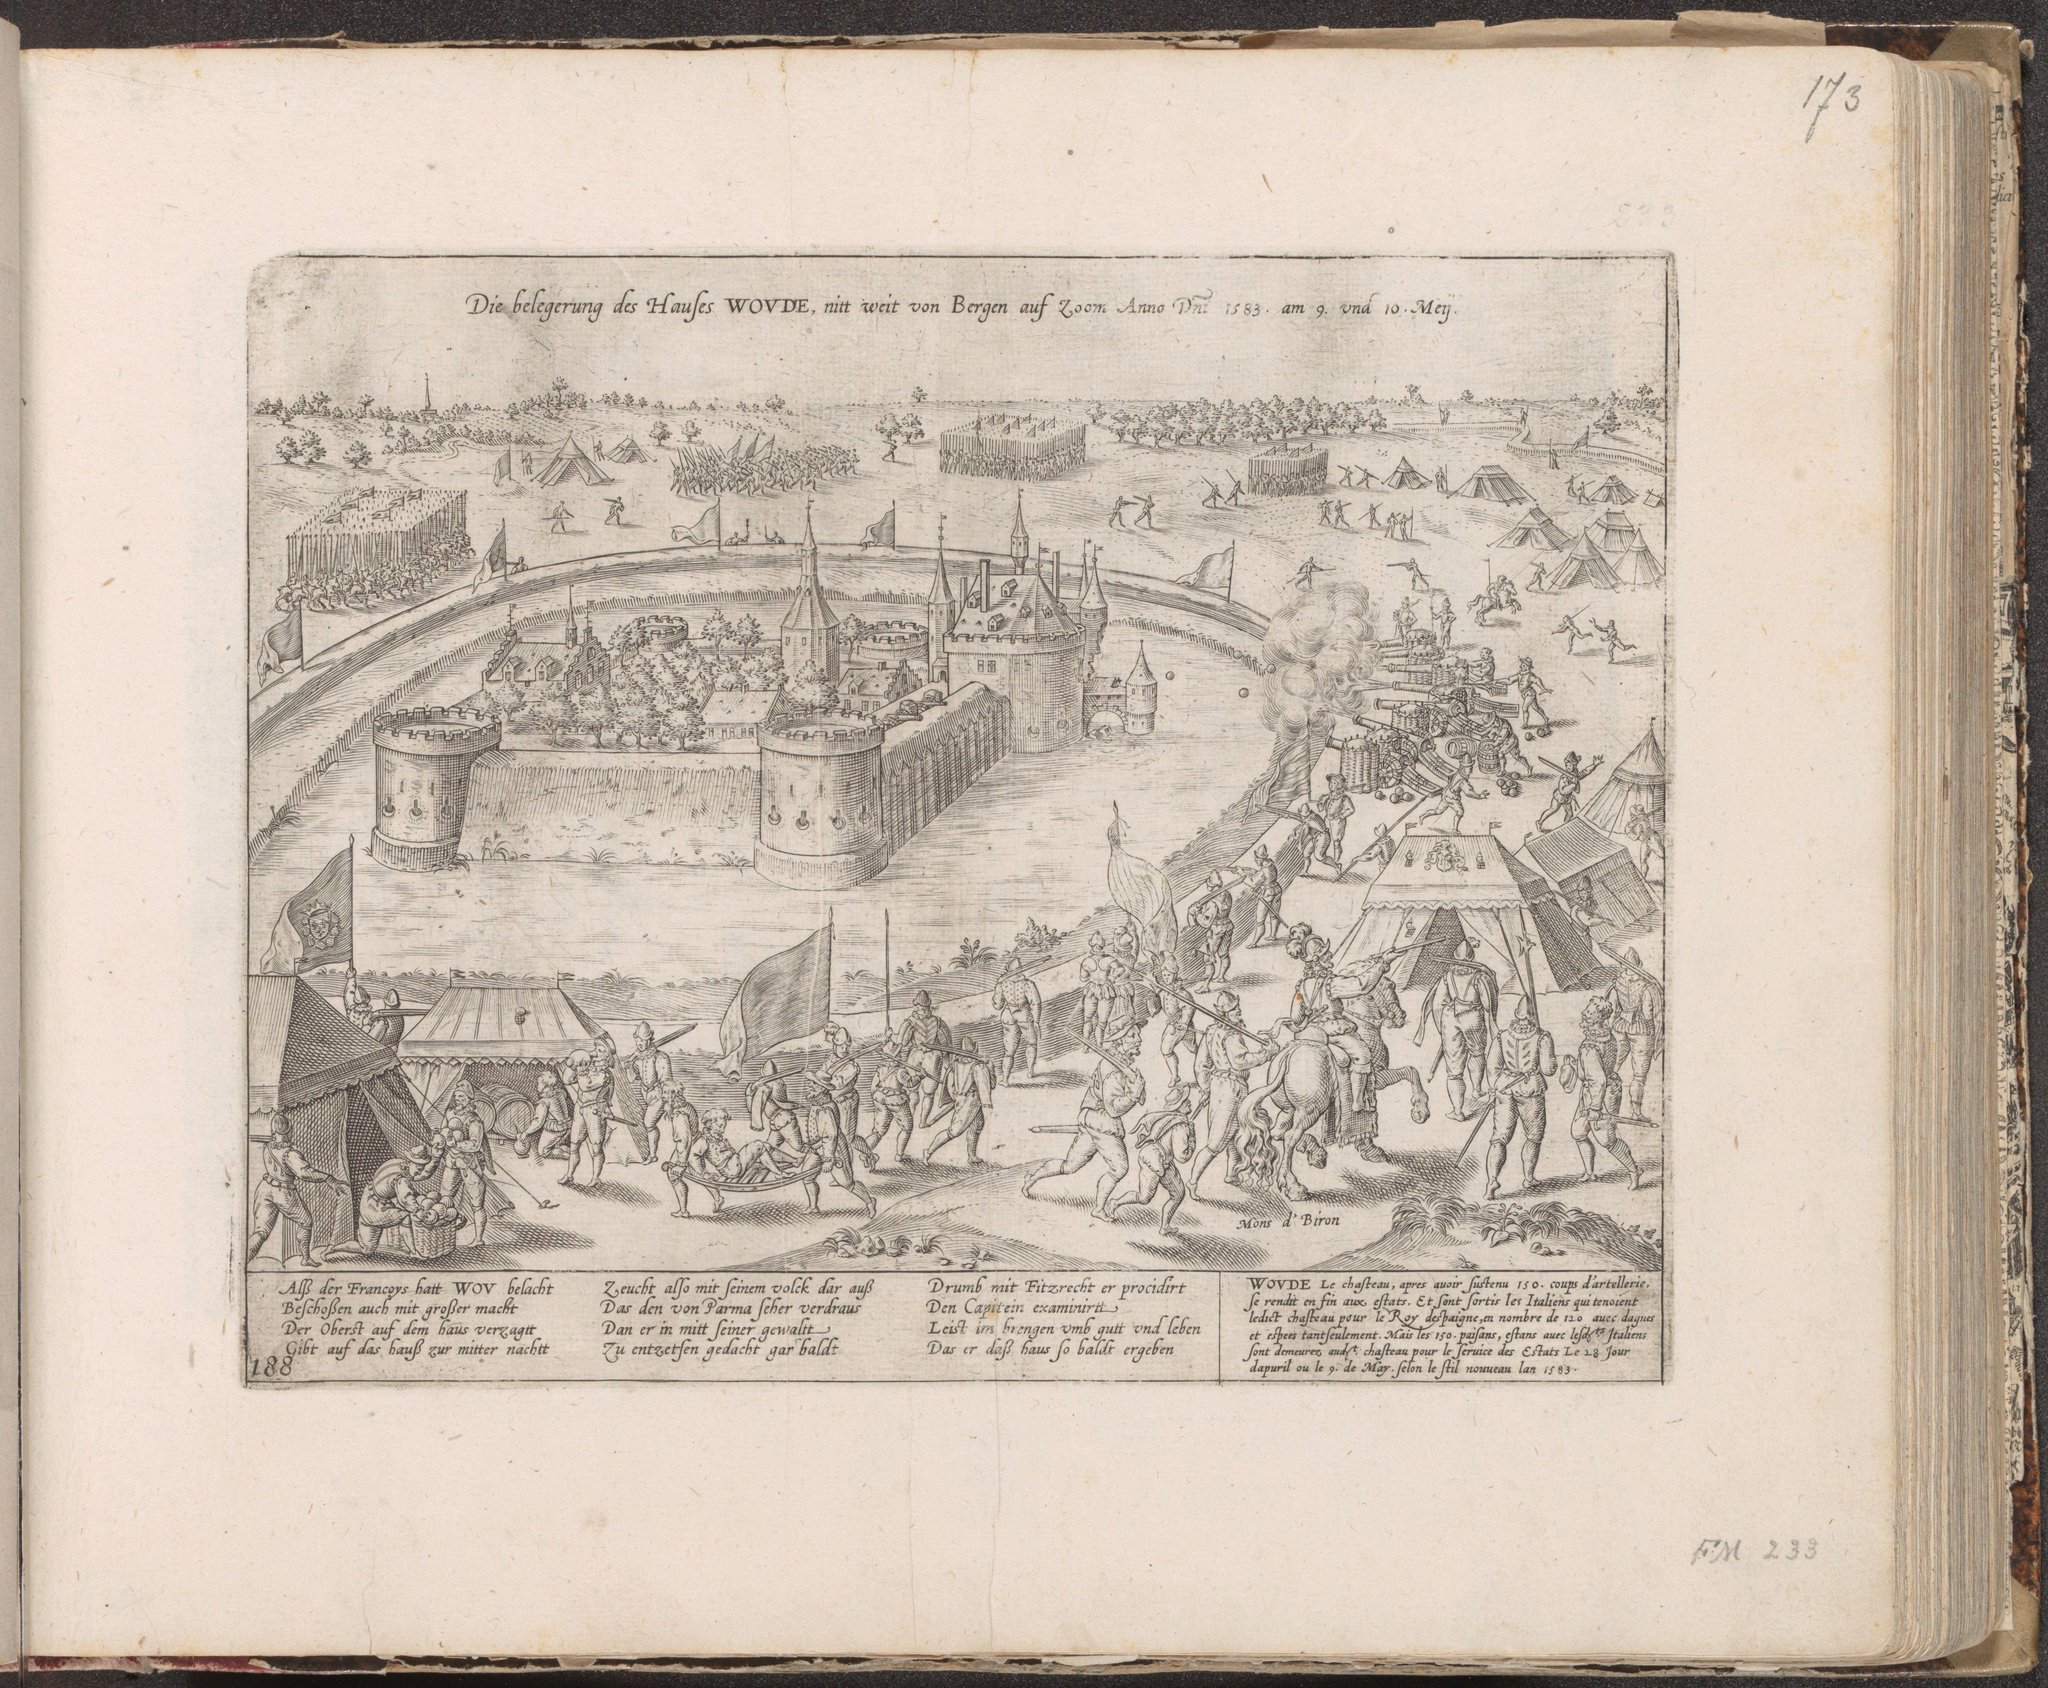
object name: print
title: Die belegerung des Hauses Woude, nitt weit von Bergen auf Zoom Anno Dni. 1583, am 9. und 10 Meij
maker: frans hogenberg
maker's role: print maker, publisher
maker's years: 1538-1590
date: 1587-1591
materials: paper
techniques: etching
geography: cologne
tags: politician, siege, position war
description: Beleg en verovering van het kasteel van Wouw bij Bergen op Zoom door het Staatse leger onder maarschalk Biron, 9 - 10 mei 1583. Met onderschrift van 12 regels in het Duits en 6 regels in het Frans. Linksonder genummerd: 188. De prent maakt deel uit van een album.